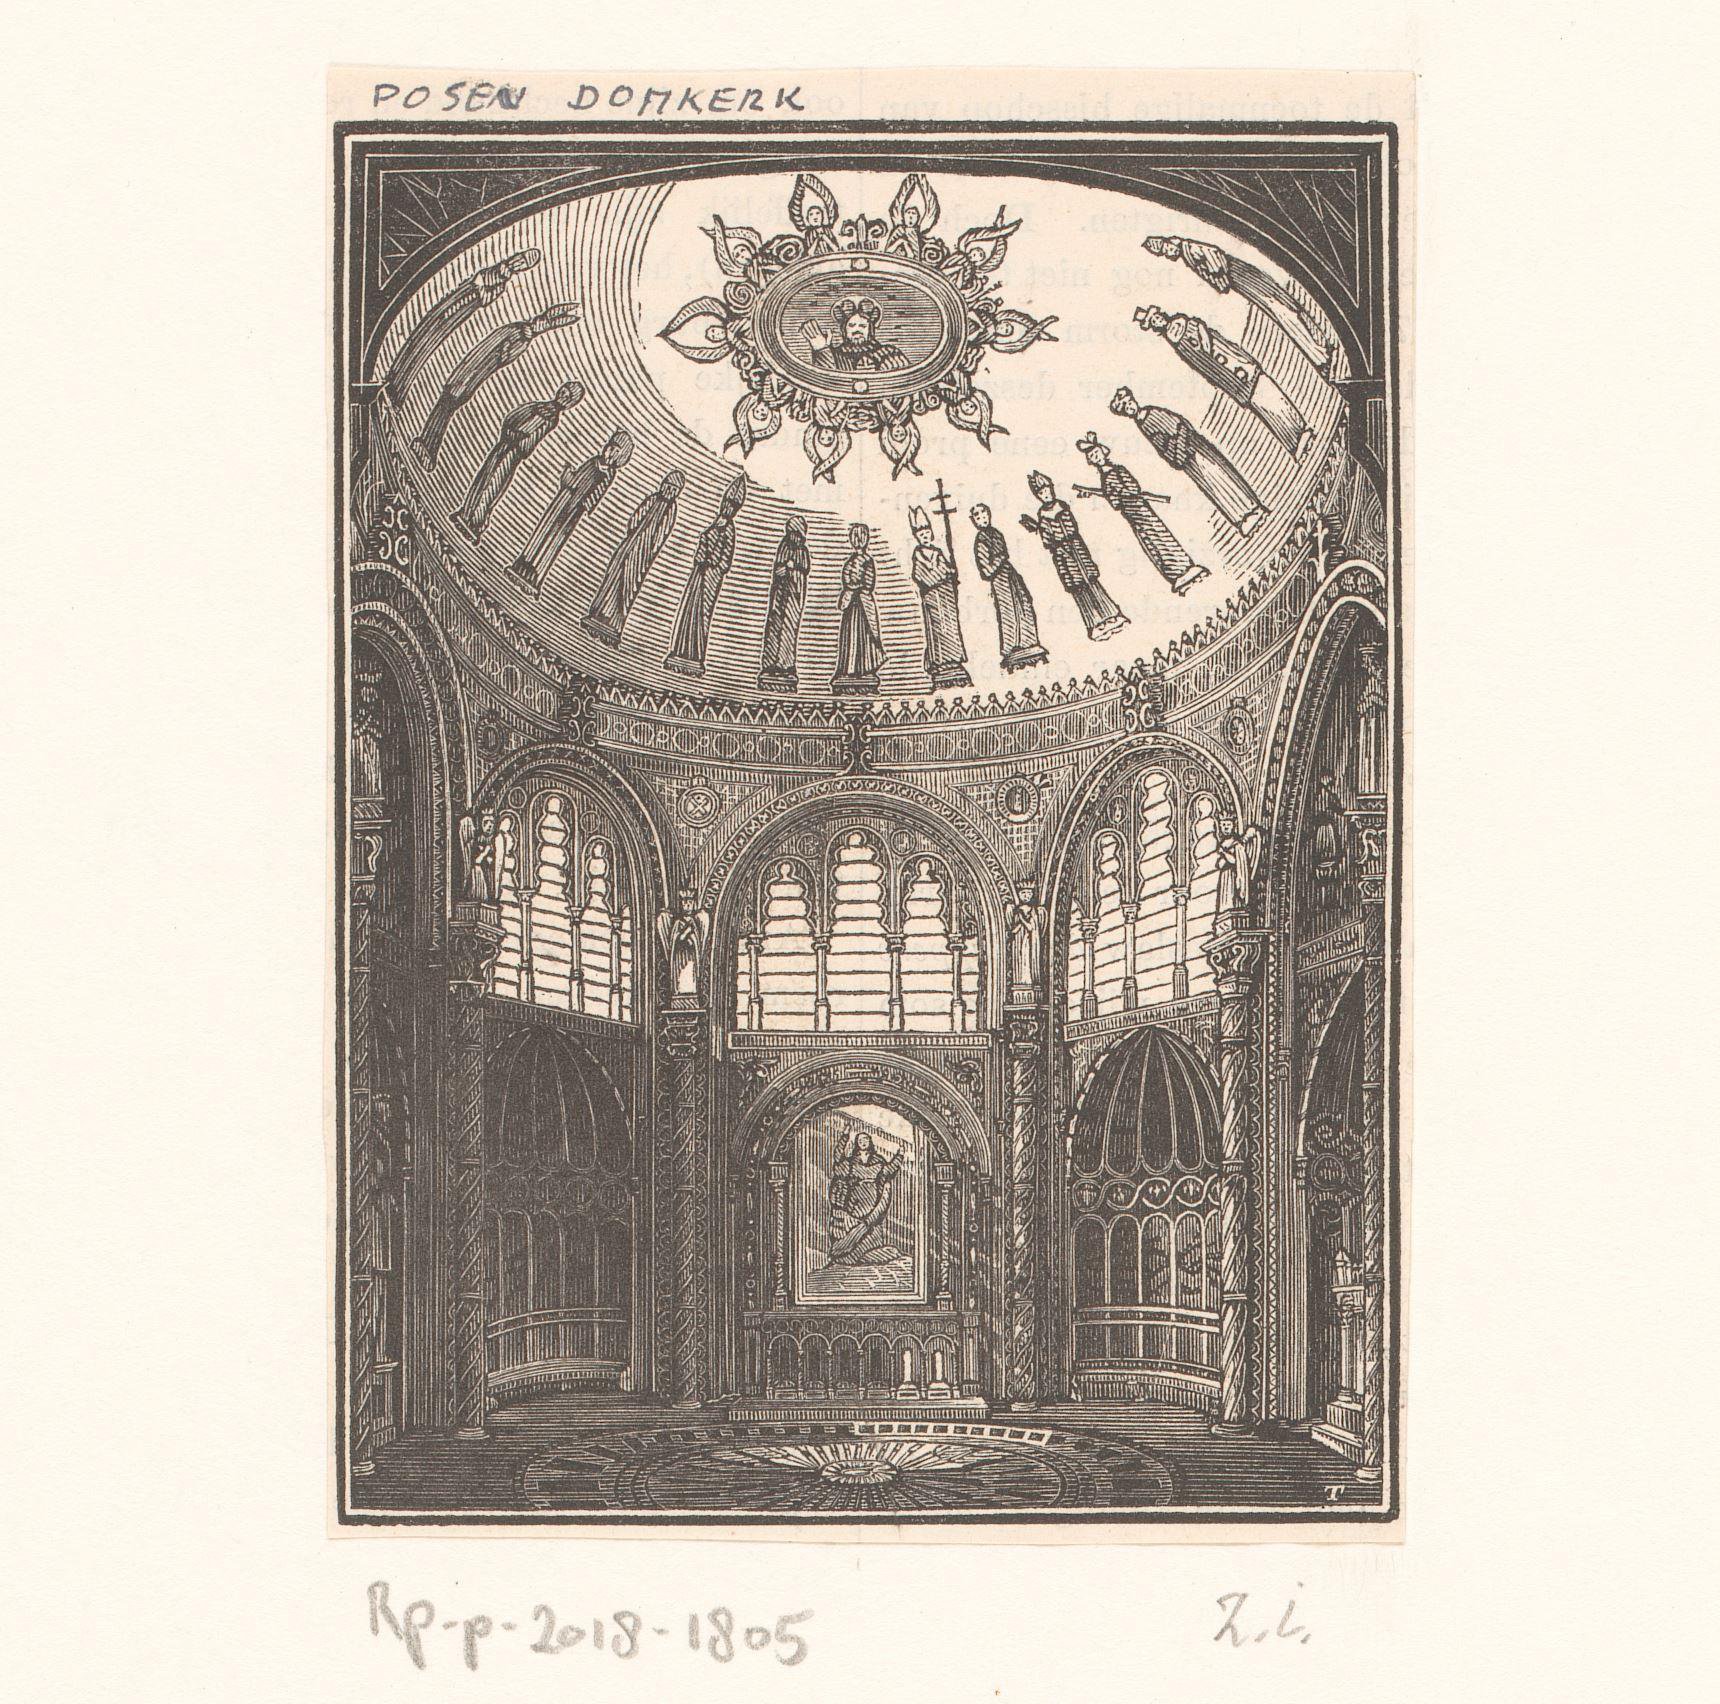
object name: book illustration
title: Gezicht op het interieur van de Sint-Petrus-en-Paulusbasiliek, te Poznań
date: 1847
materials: paper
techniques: letterpress printing, engraving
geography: amsterdam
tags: interior of church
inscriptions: collector's mark: Lugt 2228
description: Prent gebruikt in: Hollandsch Penning-Magazijn voor de jeugd. Amsterdam: J.H. Laarman, 1847.